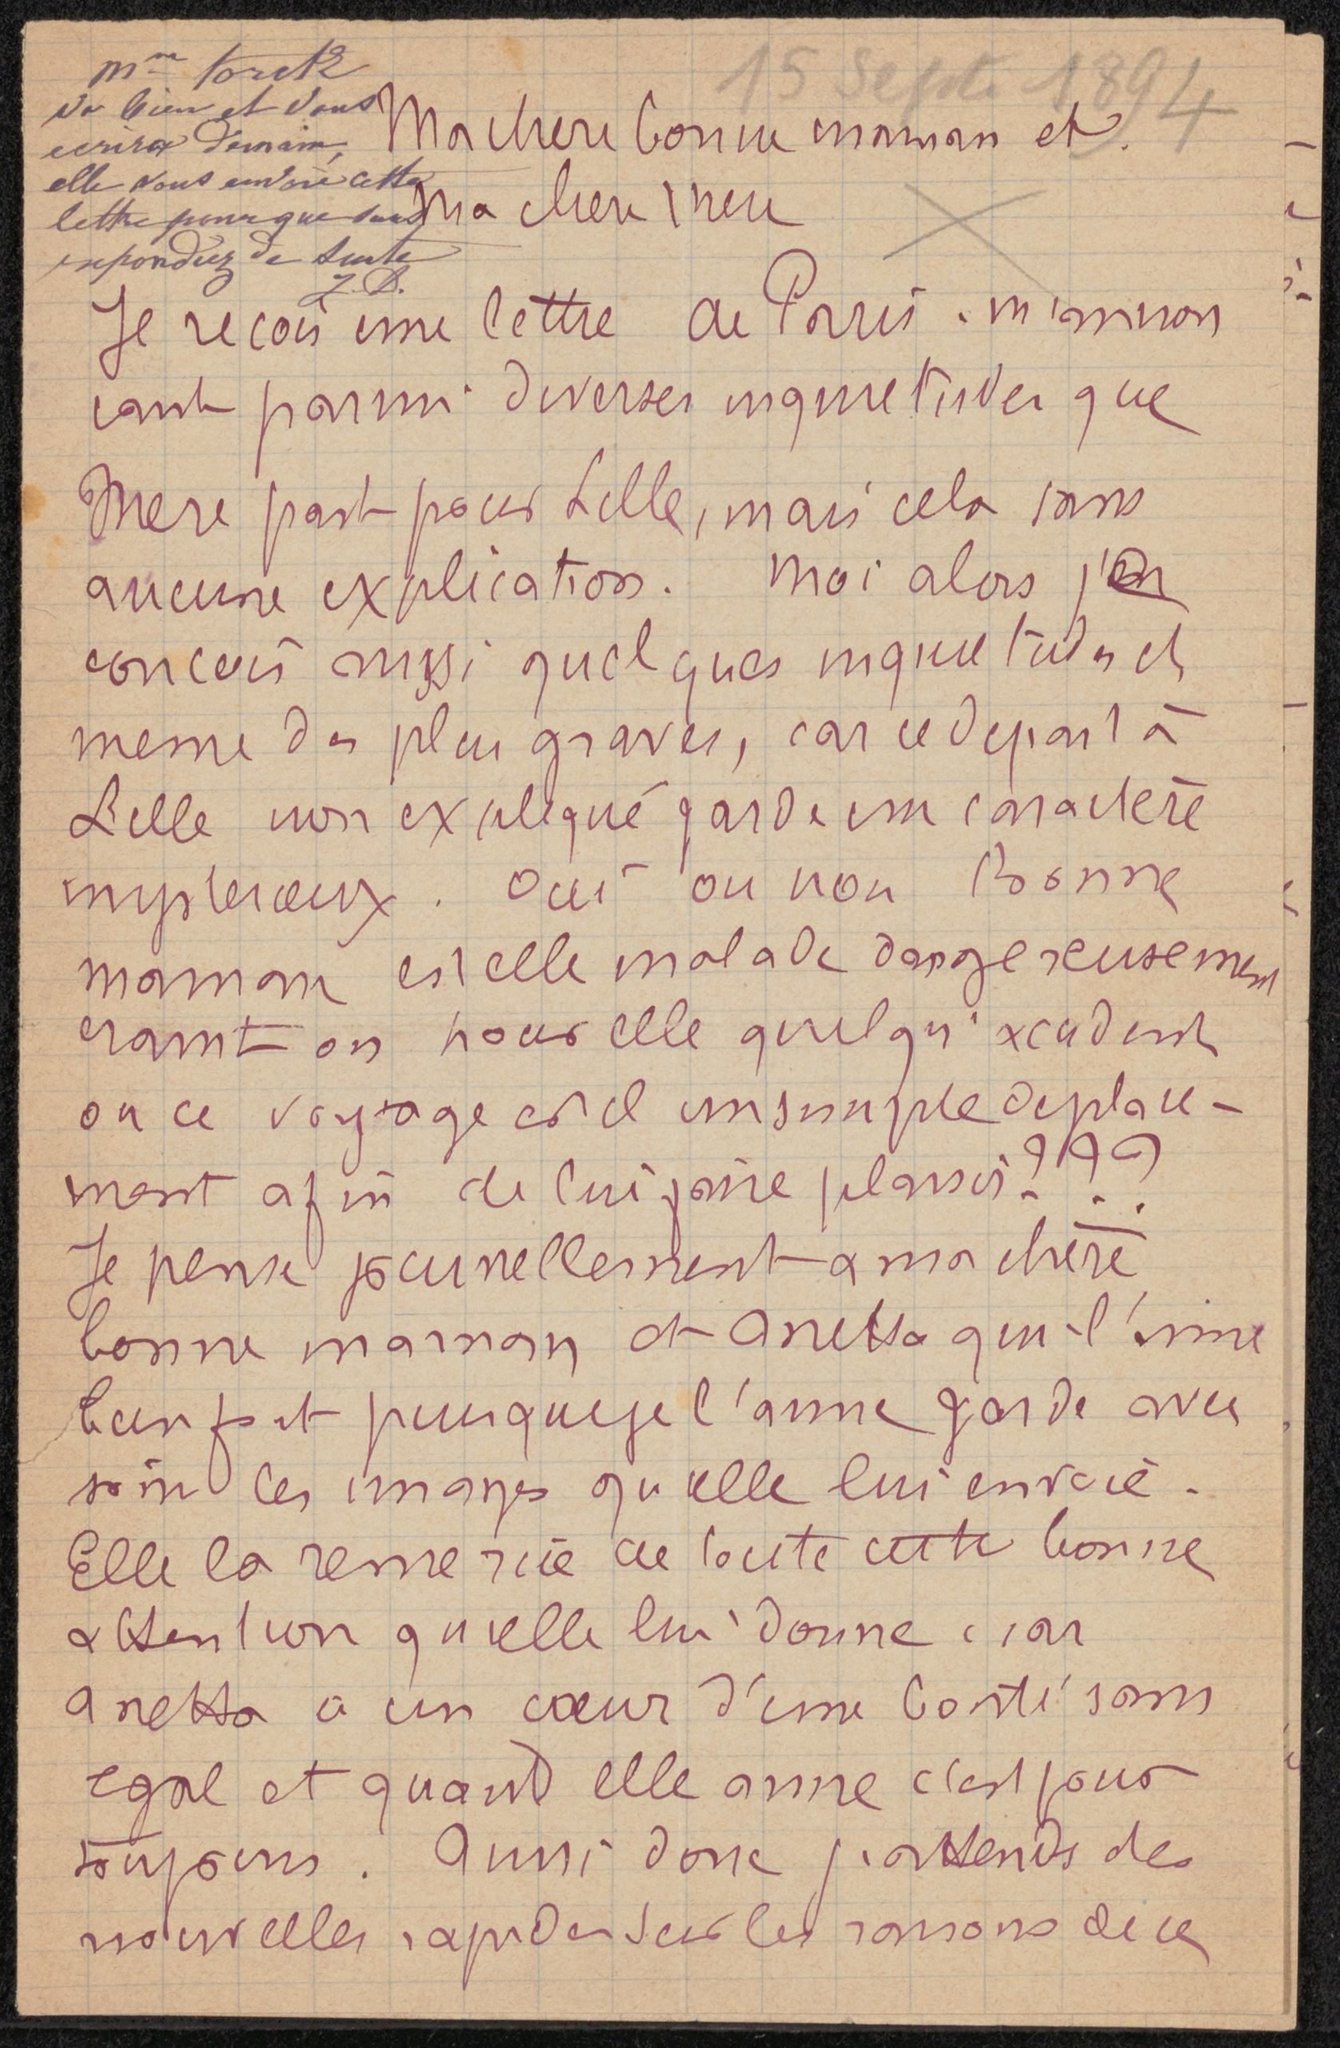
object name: letter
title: Brief aan Sophie Bodin-Lallement en Héloïse Bernard-Bodin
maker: émile bernard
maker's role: print maker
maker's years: 1868-1941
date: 1878-1941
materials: ink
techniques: pen, writing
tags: sophie bodin-lallement, héloïse bernard-bodin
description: Brief gedateerd 15 sept 1894 in latere hand.